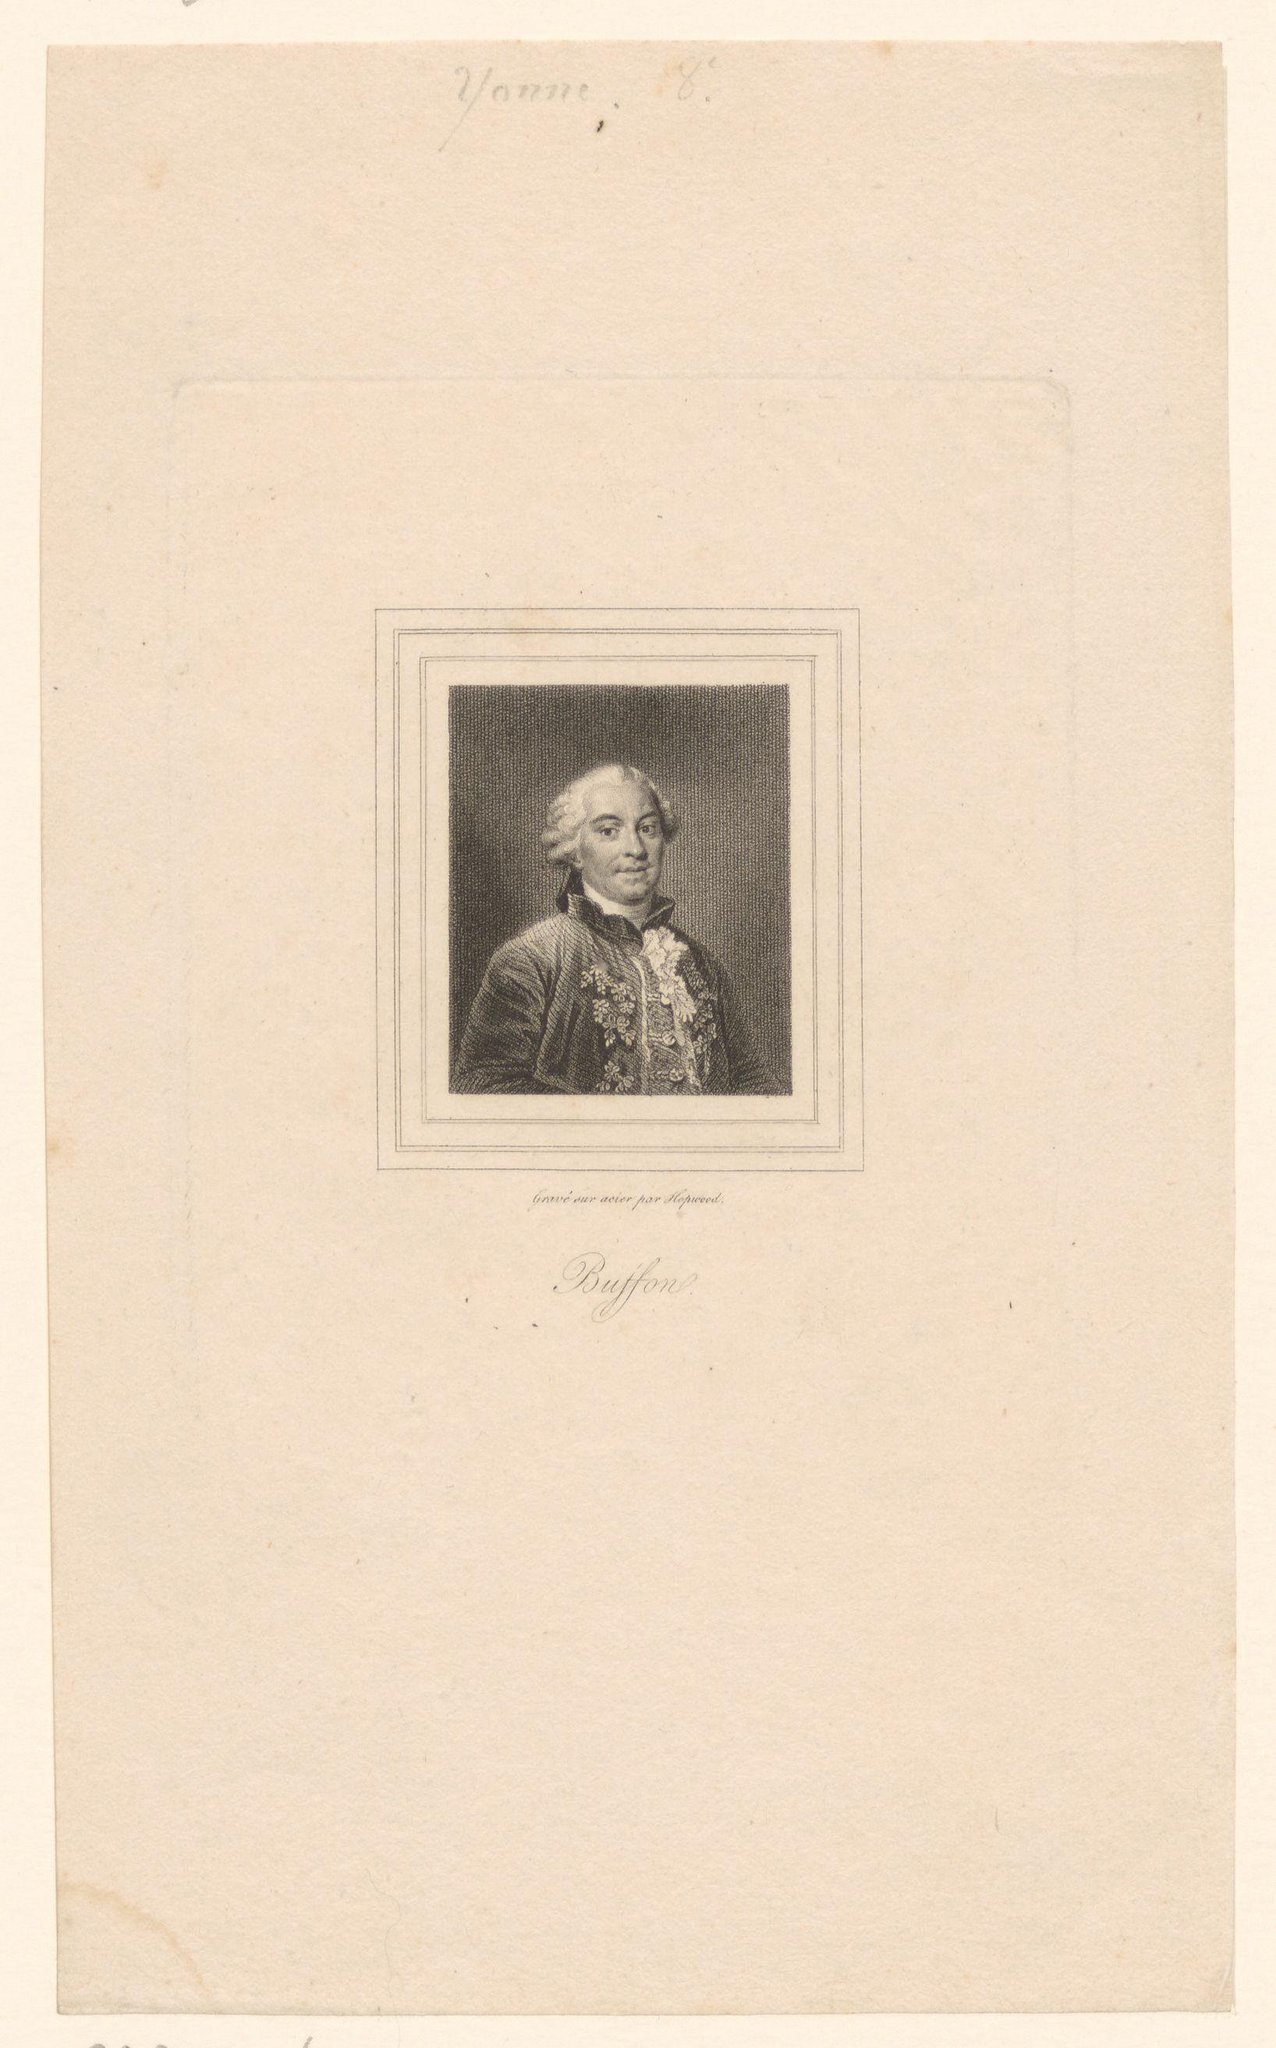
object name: print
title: Portret van Georges-Louis Leclerc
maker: james hopwood (ii)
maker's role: print maker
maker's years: 1795-1855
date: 1805-1855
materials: paper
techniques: etching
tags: earl, historical persons, mathematics (+ portrait of scholar, scientist)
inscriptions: collector's mark: Lugt 2228